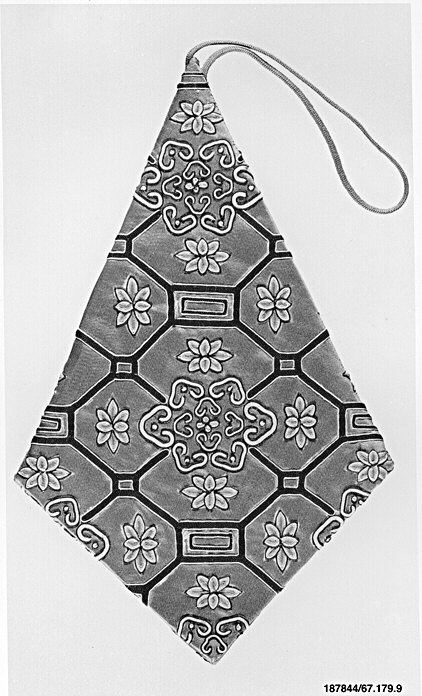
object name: case, hanging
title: Hanging Case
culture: chinese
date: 1801-1900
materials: silk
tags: flowers